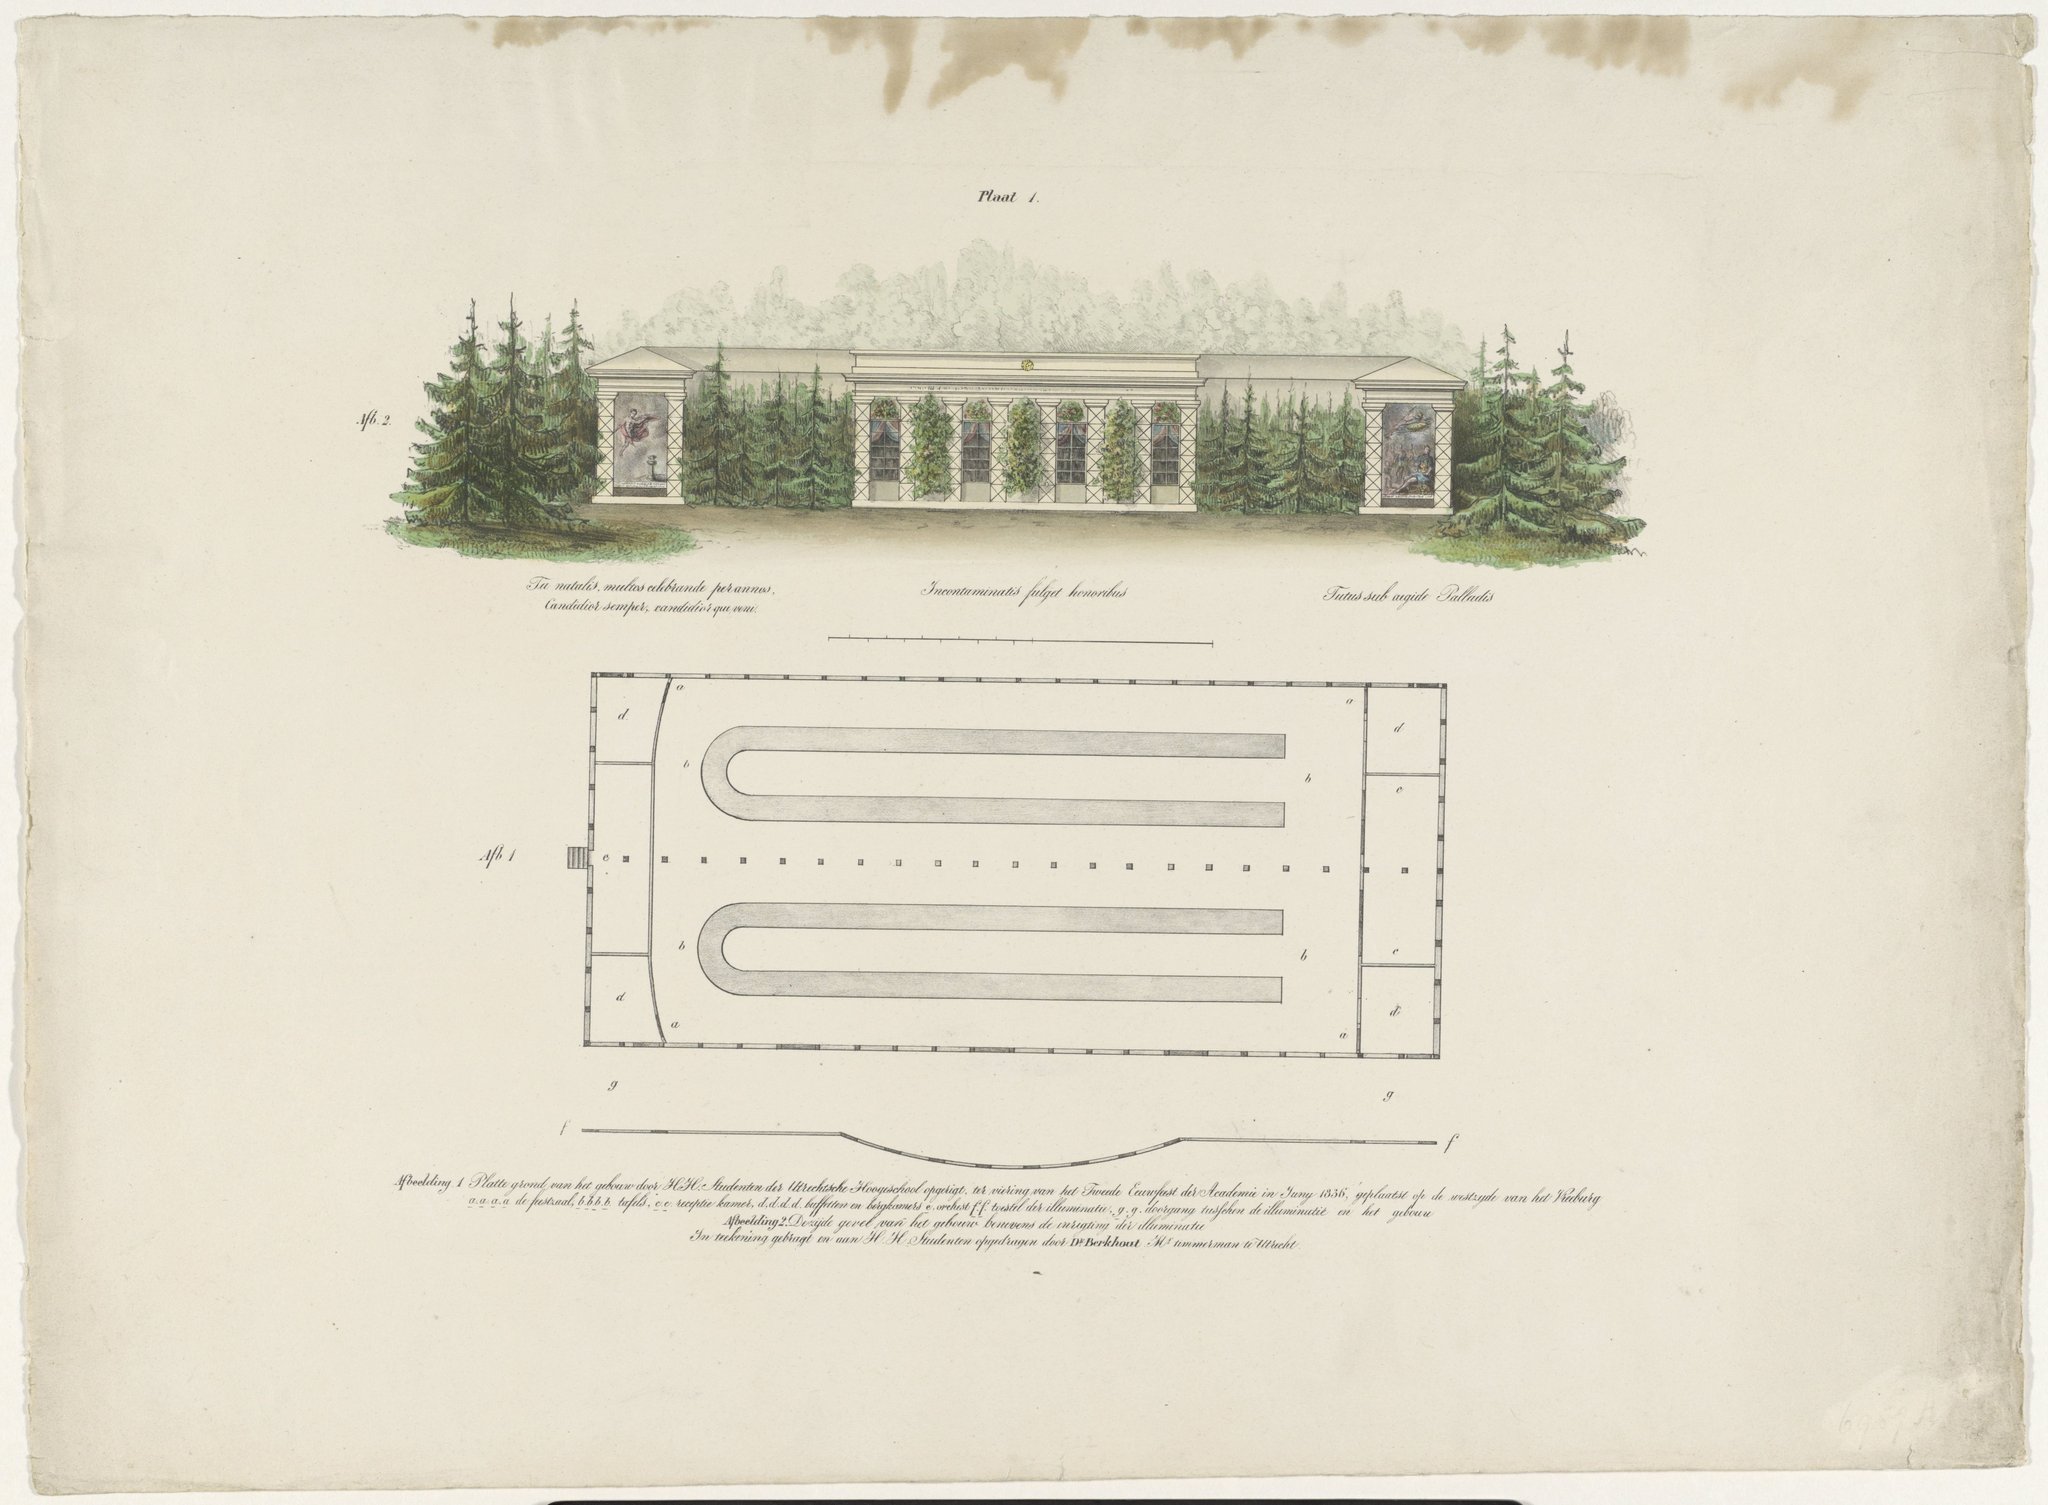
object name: print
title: Platte grond van het gebouw door H.H. Studenten der Utrechtsche Hoogeschool opgerigt, ter viering van het Tweede Eeuwfeest der Academie in Juny 1836 (...)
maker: dk. berkhout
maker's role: draughtsman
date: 1836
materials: paper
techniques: hand coloring, lithograph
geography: utrecht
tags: commemoration of the founding of a university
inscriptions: collector's mark: Lugt 2228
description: De Atlas van Stolk bezit een exemplaar van een deze twee prenten in een omslag waarop staat vermeld 'Uit de steendrukkerij van Gebr.s van de Weijer' en 'Geteekend en uitgegeven door D.k Berkhout Mr timmerman te Utrecht.' Niet in Frederik Muller; door het RPK toegevoegd nummer.